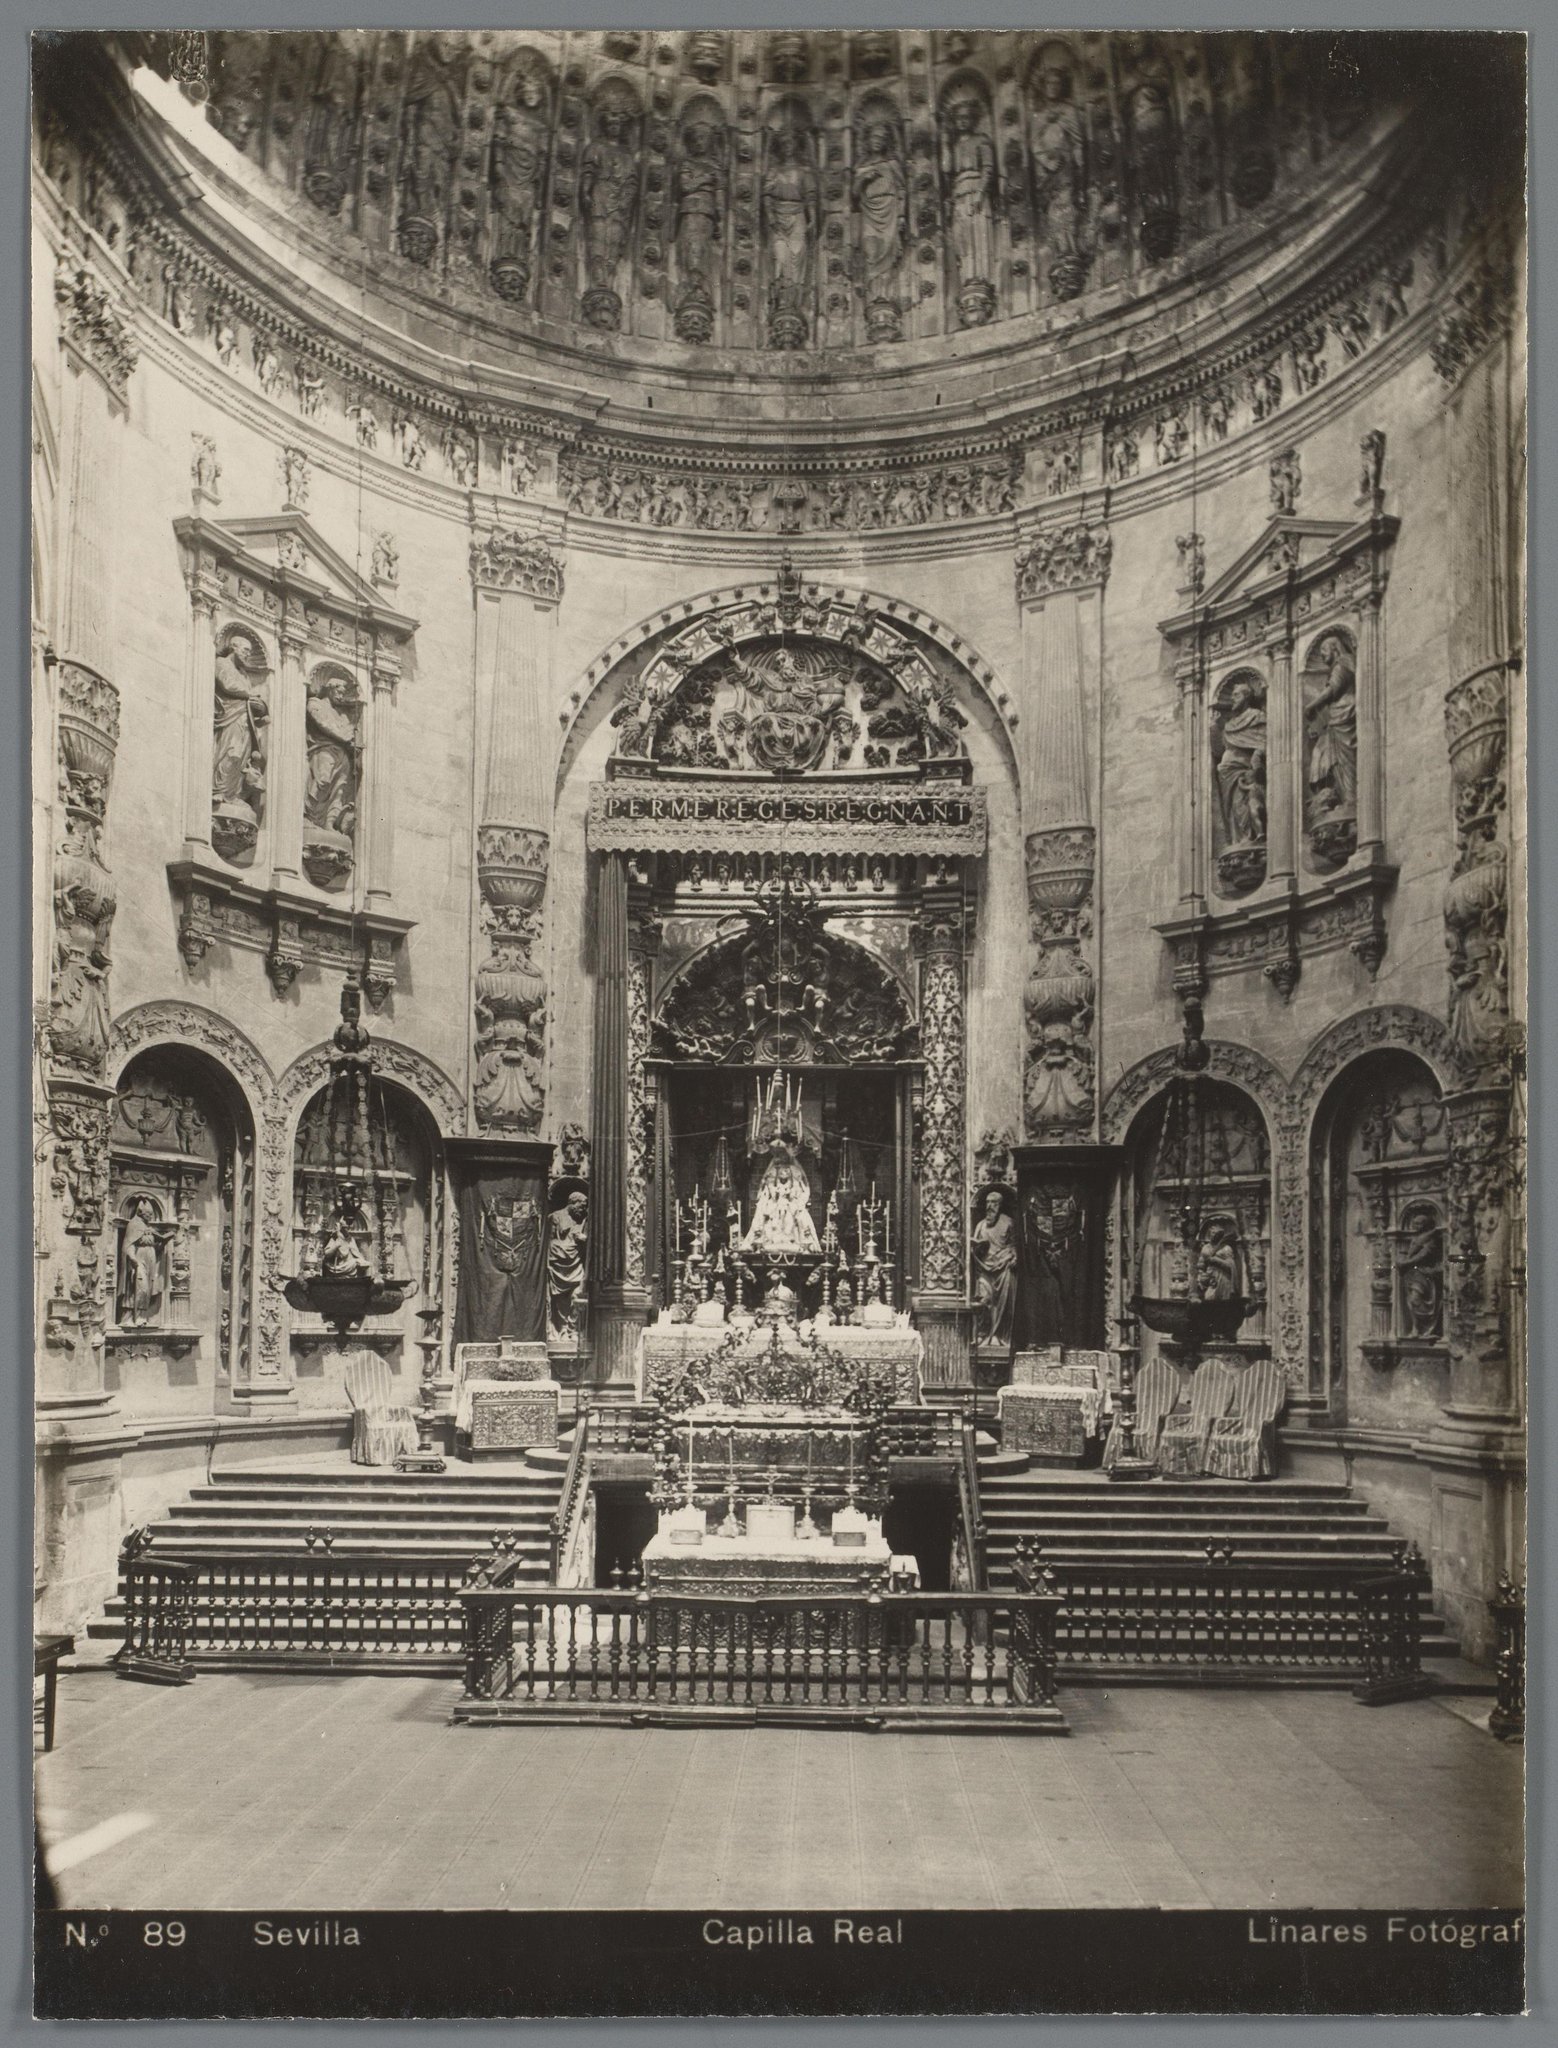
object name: photograph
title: Interieur van de Koninklijke Kapel van de Kathedraal van Sevilla, Spanje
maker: f. linares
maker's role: publisher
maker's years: 1870-1937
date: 1914-1937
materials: photographic support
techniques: gelatin silver print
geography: sevilla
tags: parts of church interior: chapel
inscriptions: number